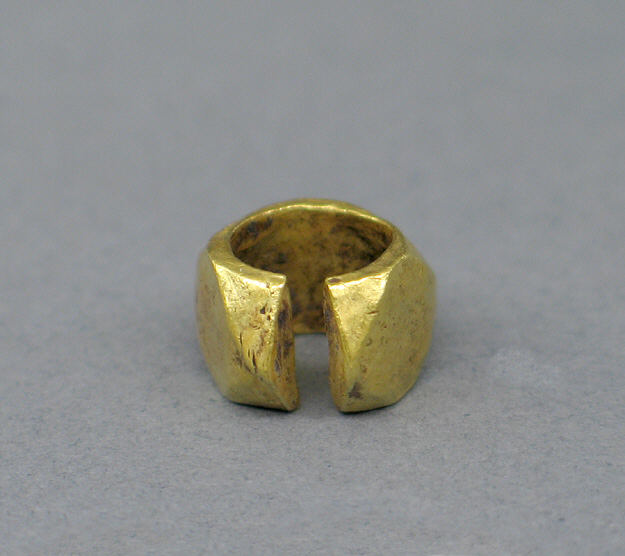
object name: ear clip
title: Pair of Triangular Ear Clips with Circular Openings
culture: indonesian, javanese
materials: gold